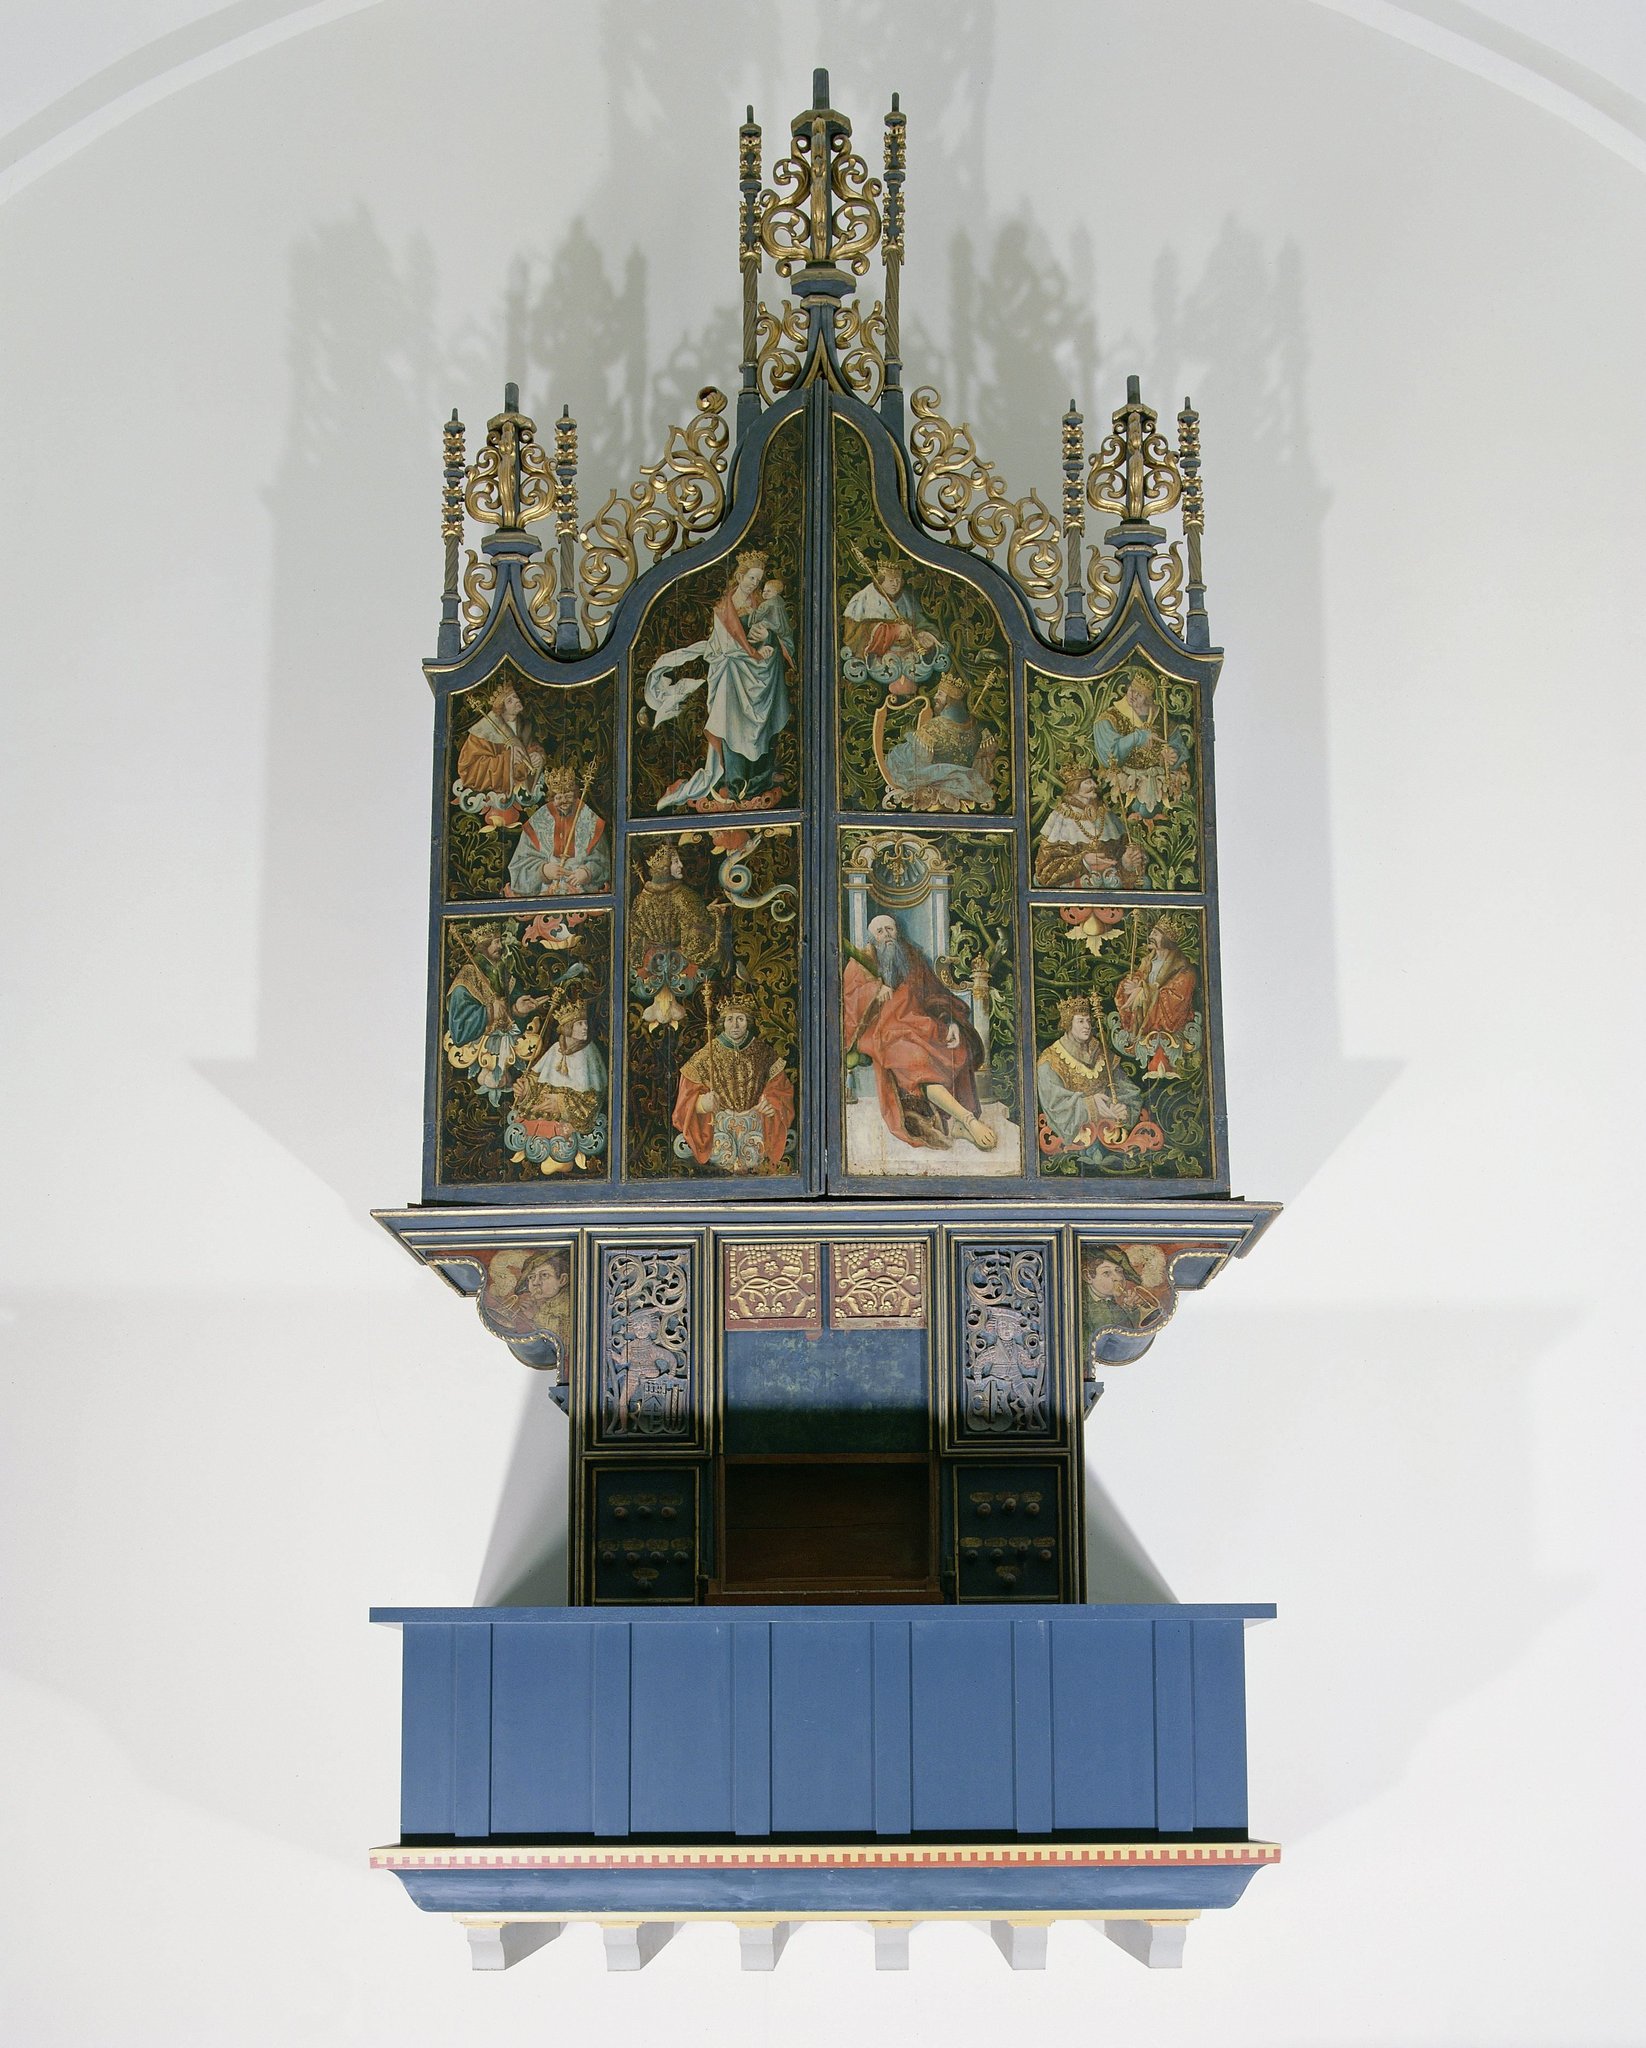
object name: organ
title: Organ from the Dutch Reformed Church at Scheemda with depiction of Jesse Tree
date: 1526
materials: wood, oil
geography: northern netherlands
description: Orgel van gepolychromeerd eikenhout uit de Nederlands Hervormde Kerk te Scheemda. De pijpenbundels zijn in zeven groepen verdeeld. Op de rechter deur aan de binnenzijde zijn voorstellingeen van De Geboorte en De Aanbidding der Herders aangebracht. Op de linkerdeur aan de binnenzijde De Aanbidding der Koningen. De buitenzijde is beschilderd met De boom van Jesse.